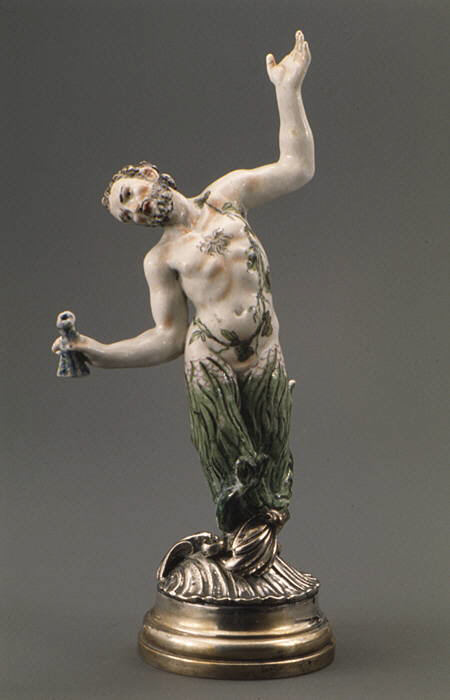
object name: figure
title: Merman (one of six)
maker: doccia porcelain manufactory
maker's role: manufactory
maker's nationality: italian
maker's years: 1737-1896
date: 1750-1755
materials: hard paste porcelain, silver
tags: mermen